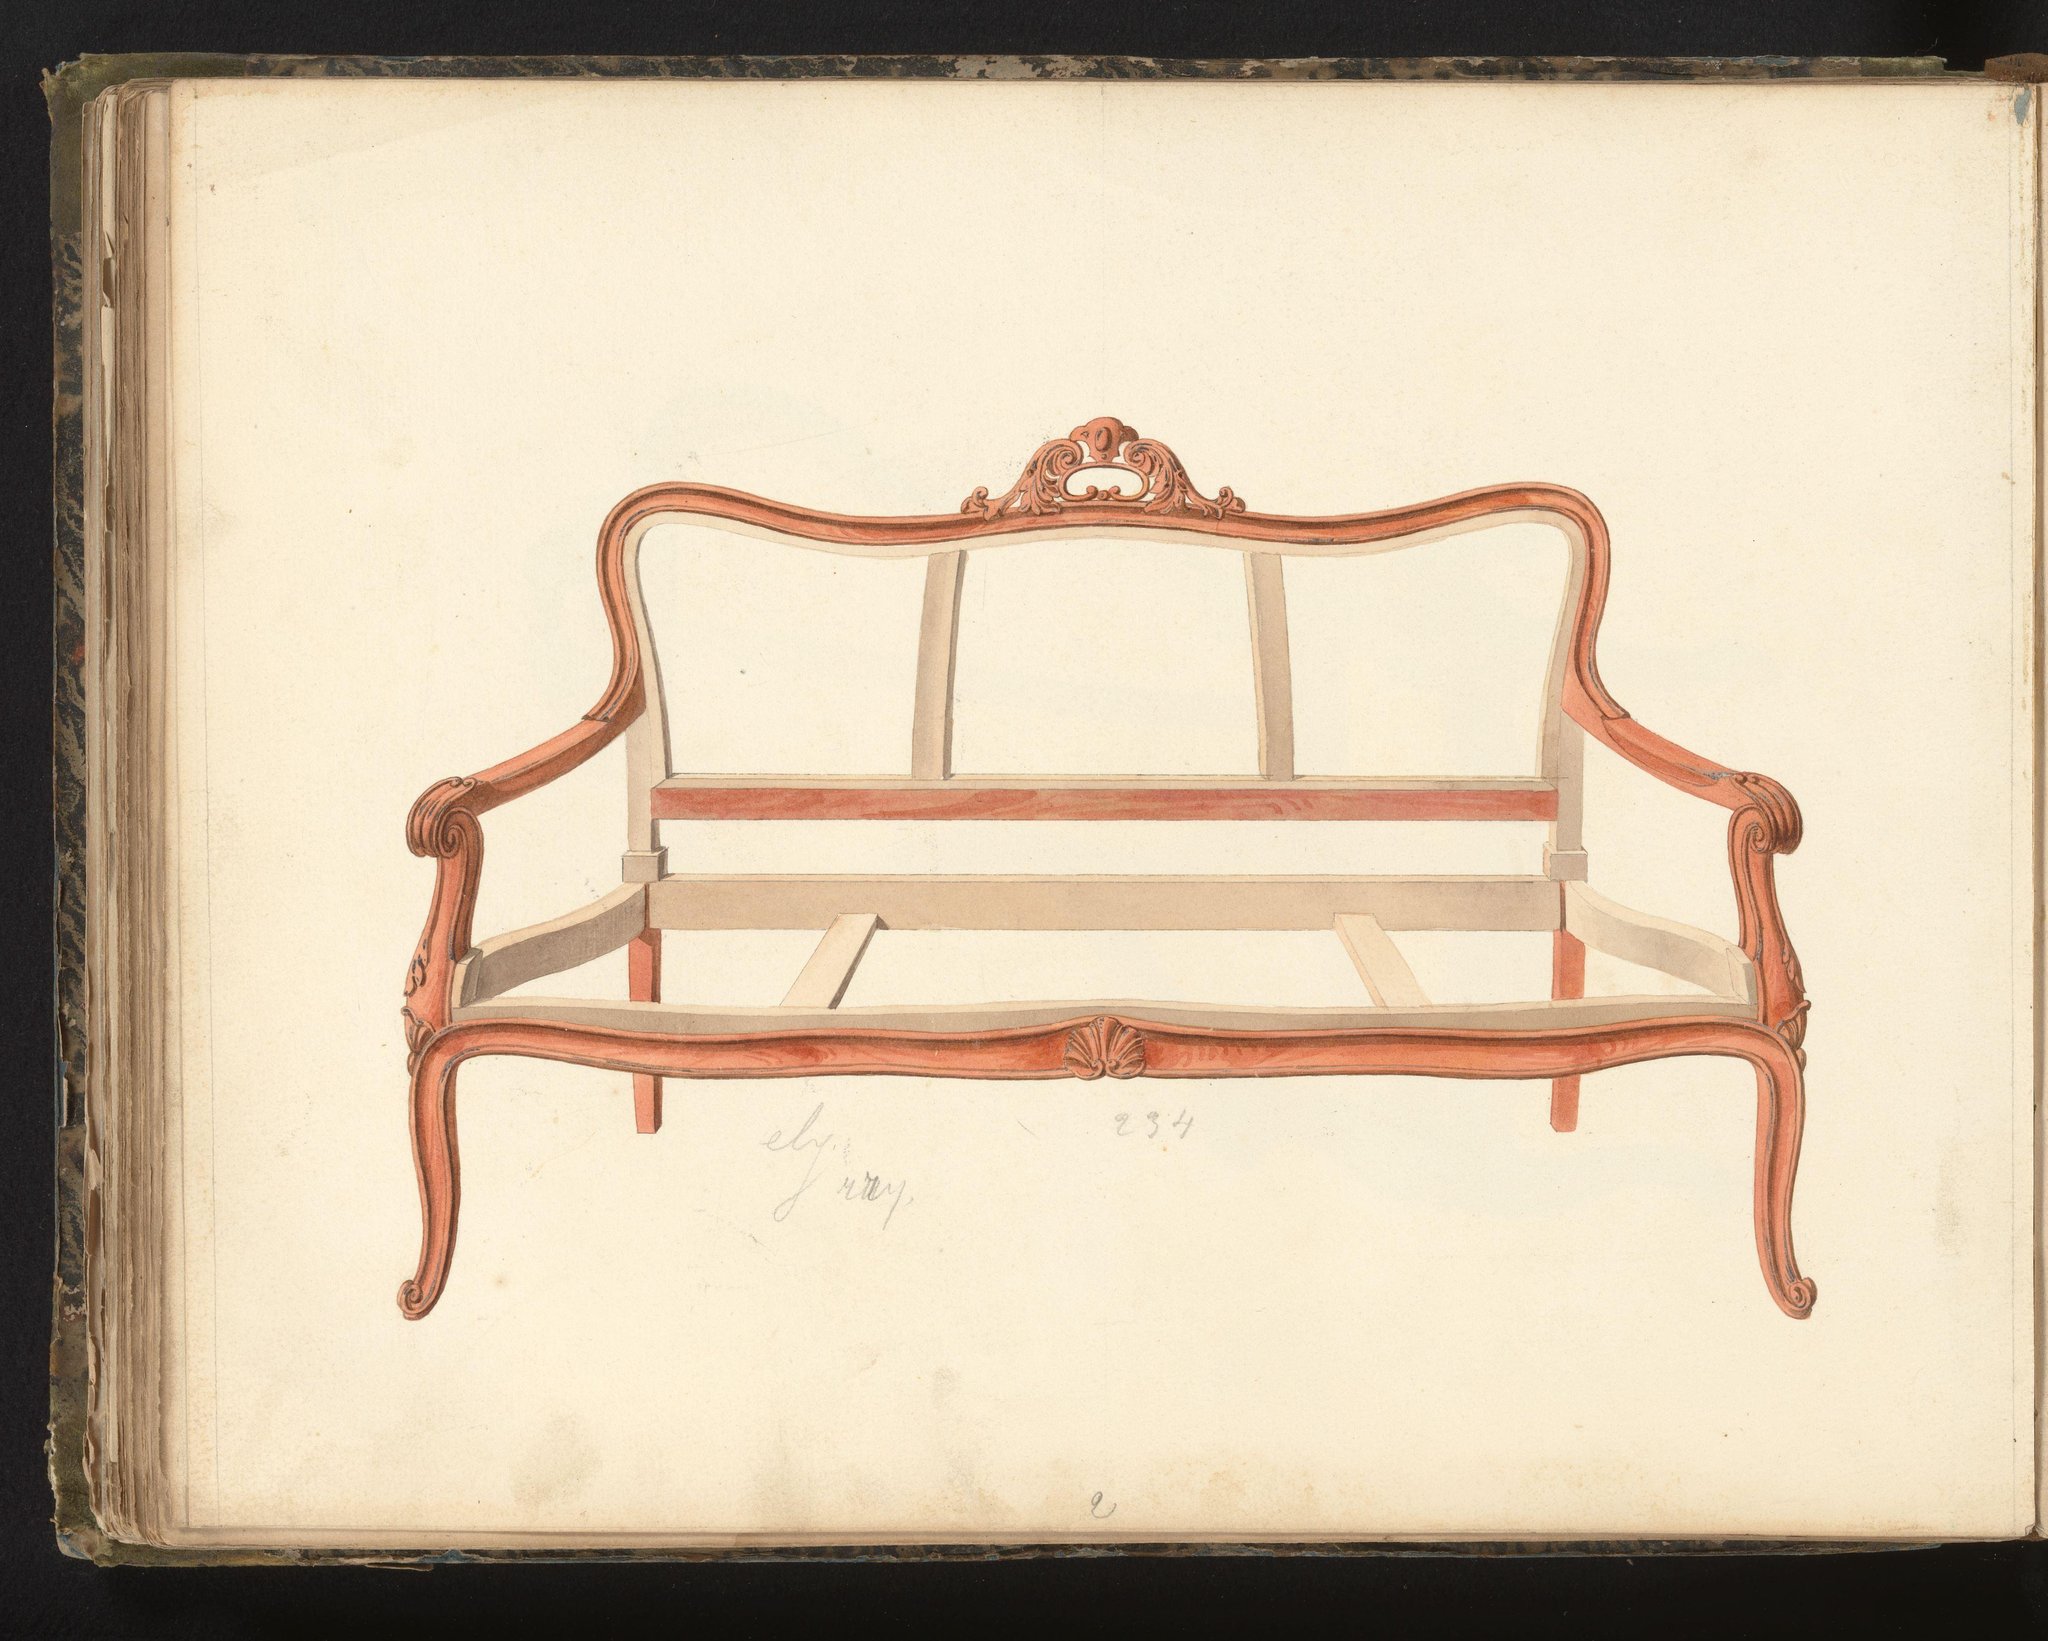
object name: drawing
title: Ontwerp voor een bank in Lodewijk XV-stijl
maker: Anonymous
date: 1825-1839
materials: ink, paper, pencil, watercolor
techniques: brush, pen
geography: paris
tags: couch, sofa, settee (+ wood and other phytogenic material)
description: Ontwerp voor een bank versierd met houtsnijwerk, zonder zitting en rugbekleding. Lodewijk XV-stijl. Het blad op de achterzijde genummerd: 70, het tegenoverliggende blad met informatie (ontbreekt hier) over de afgebeelde meubelen genummerd: 70 bis. Onderdeel van een album met 80 bladen met tekeningen en een prent van gefineerde en gelakte meubelen, alsmede zitmeubelen.